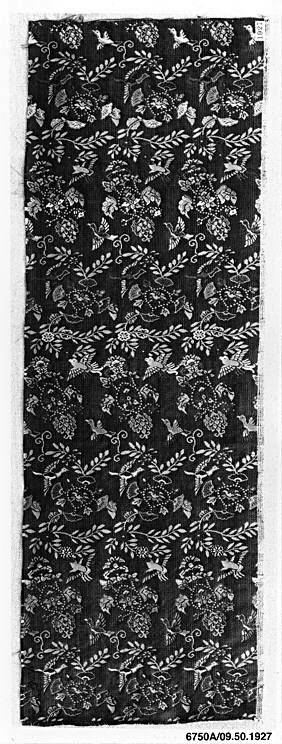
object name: piece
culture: japanese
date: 1801-1900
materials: silk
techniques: brocade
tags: birds,leaves